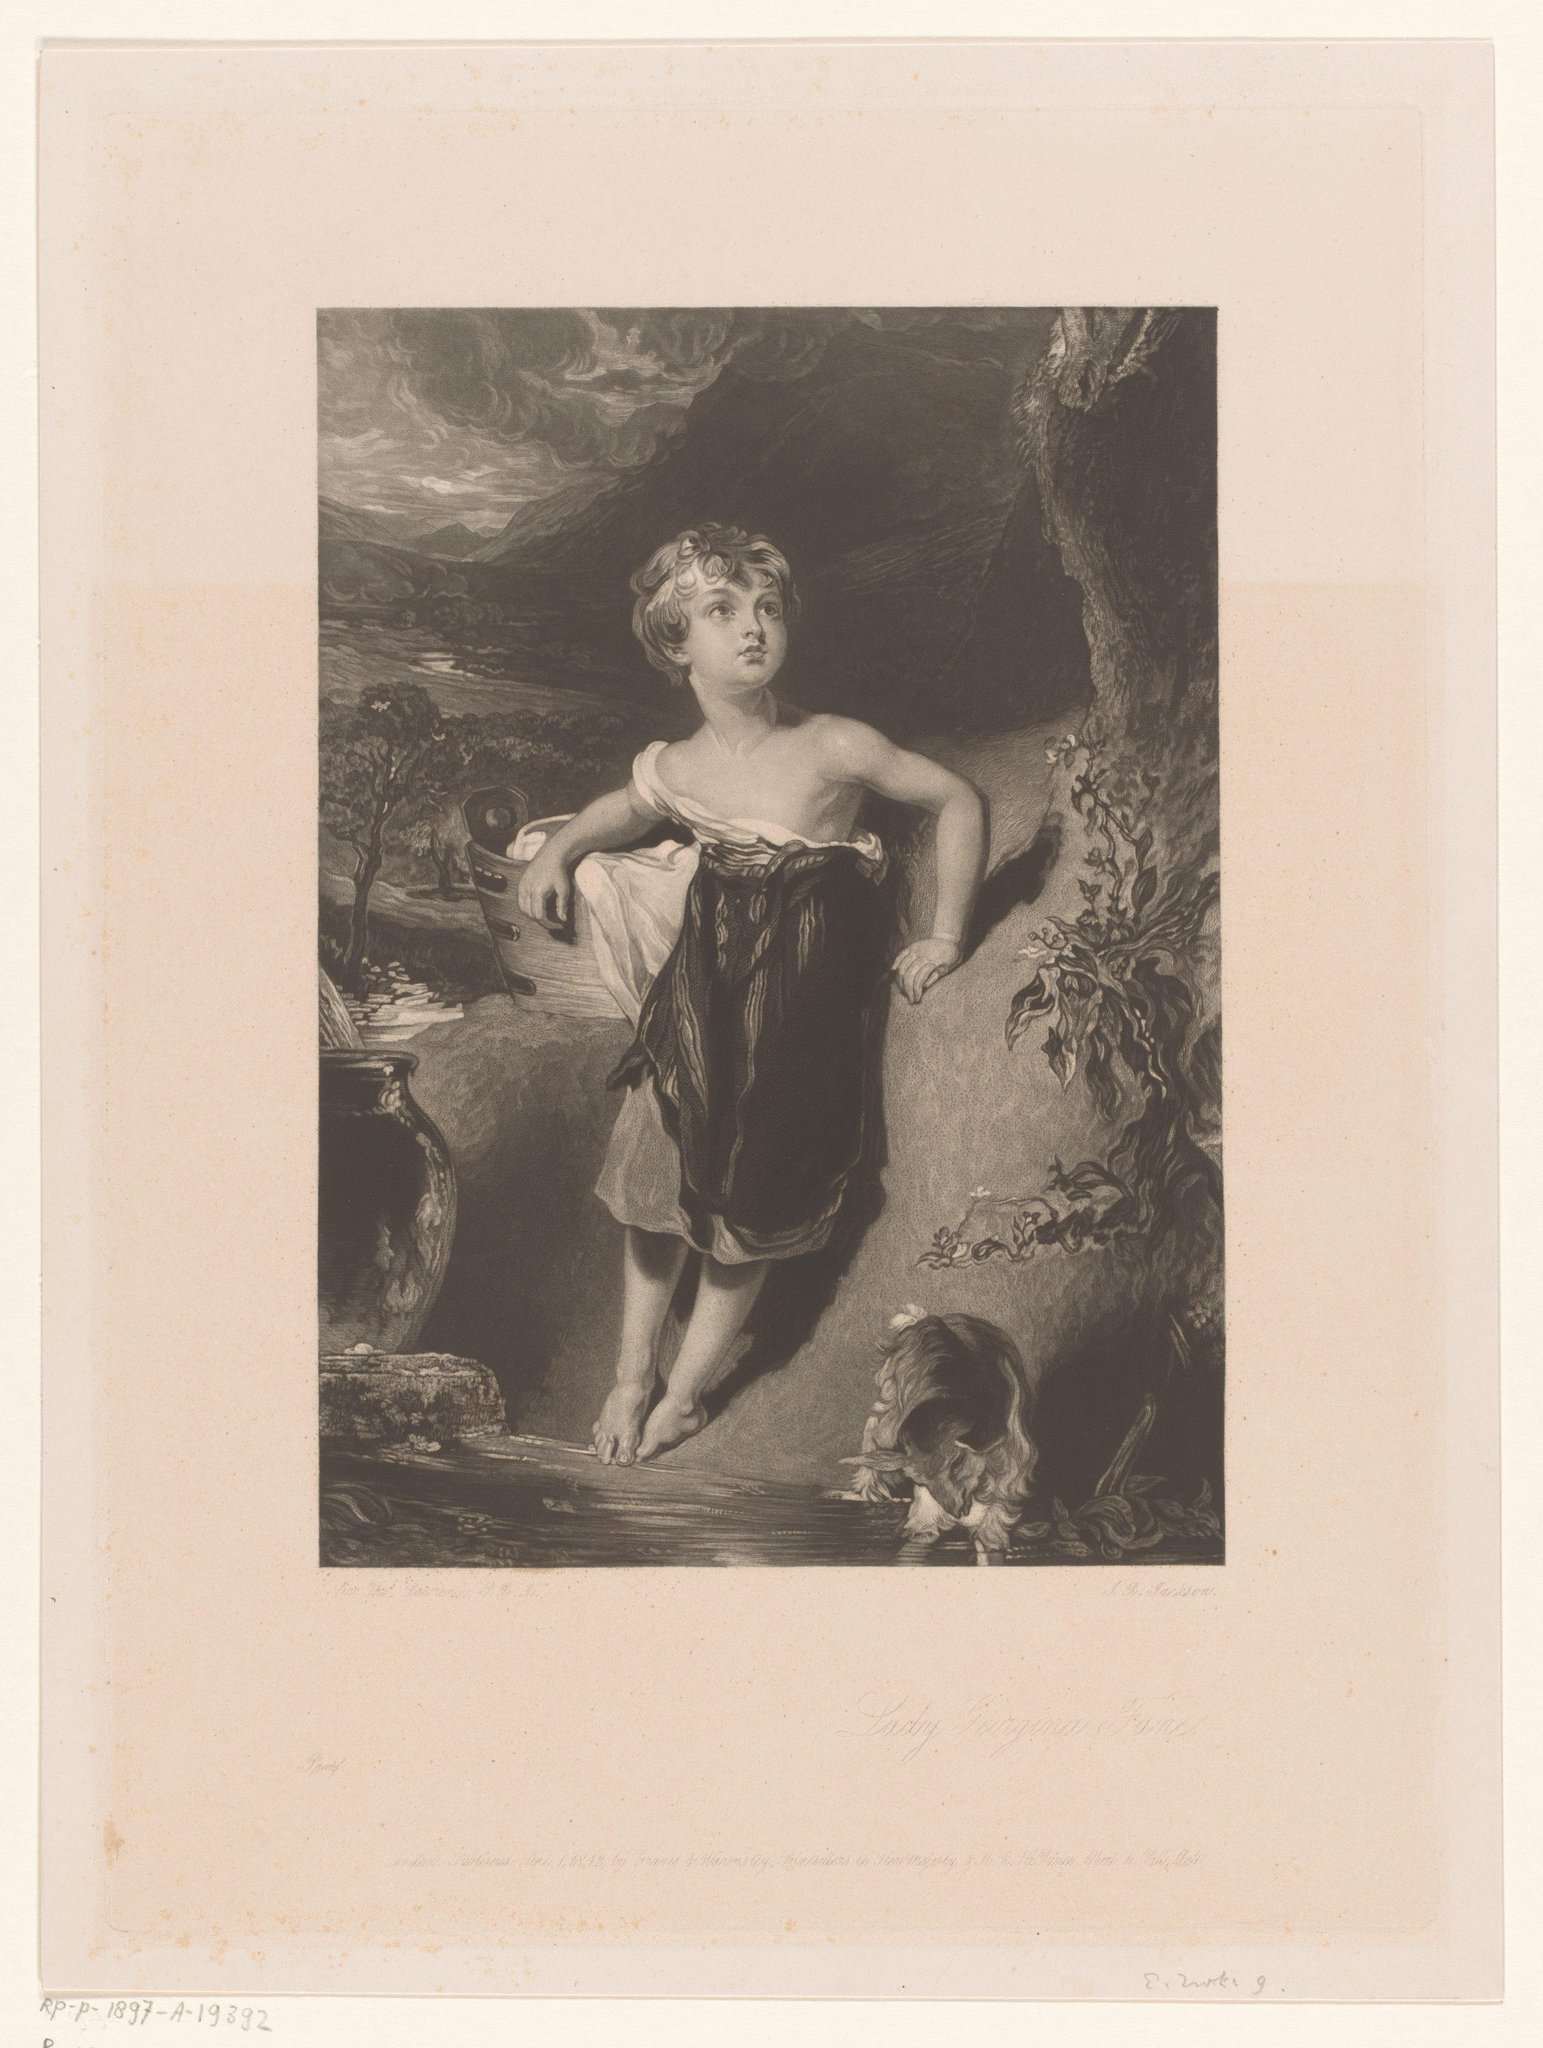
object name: print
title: Lady Georgina Fane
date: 1842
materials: paper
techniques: mezzotint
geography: london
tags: historical persons, girl (child between toddler and youth)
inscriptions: collector's mark: Lugt 2228